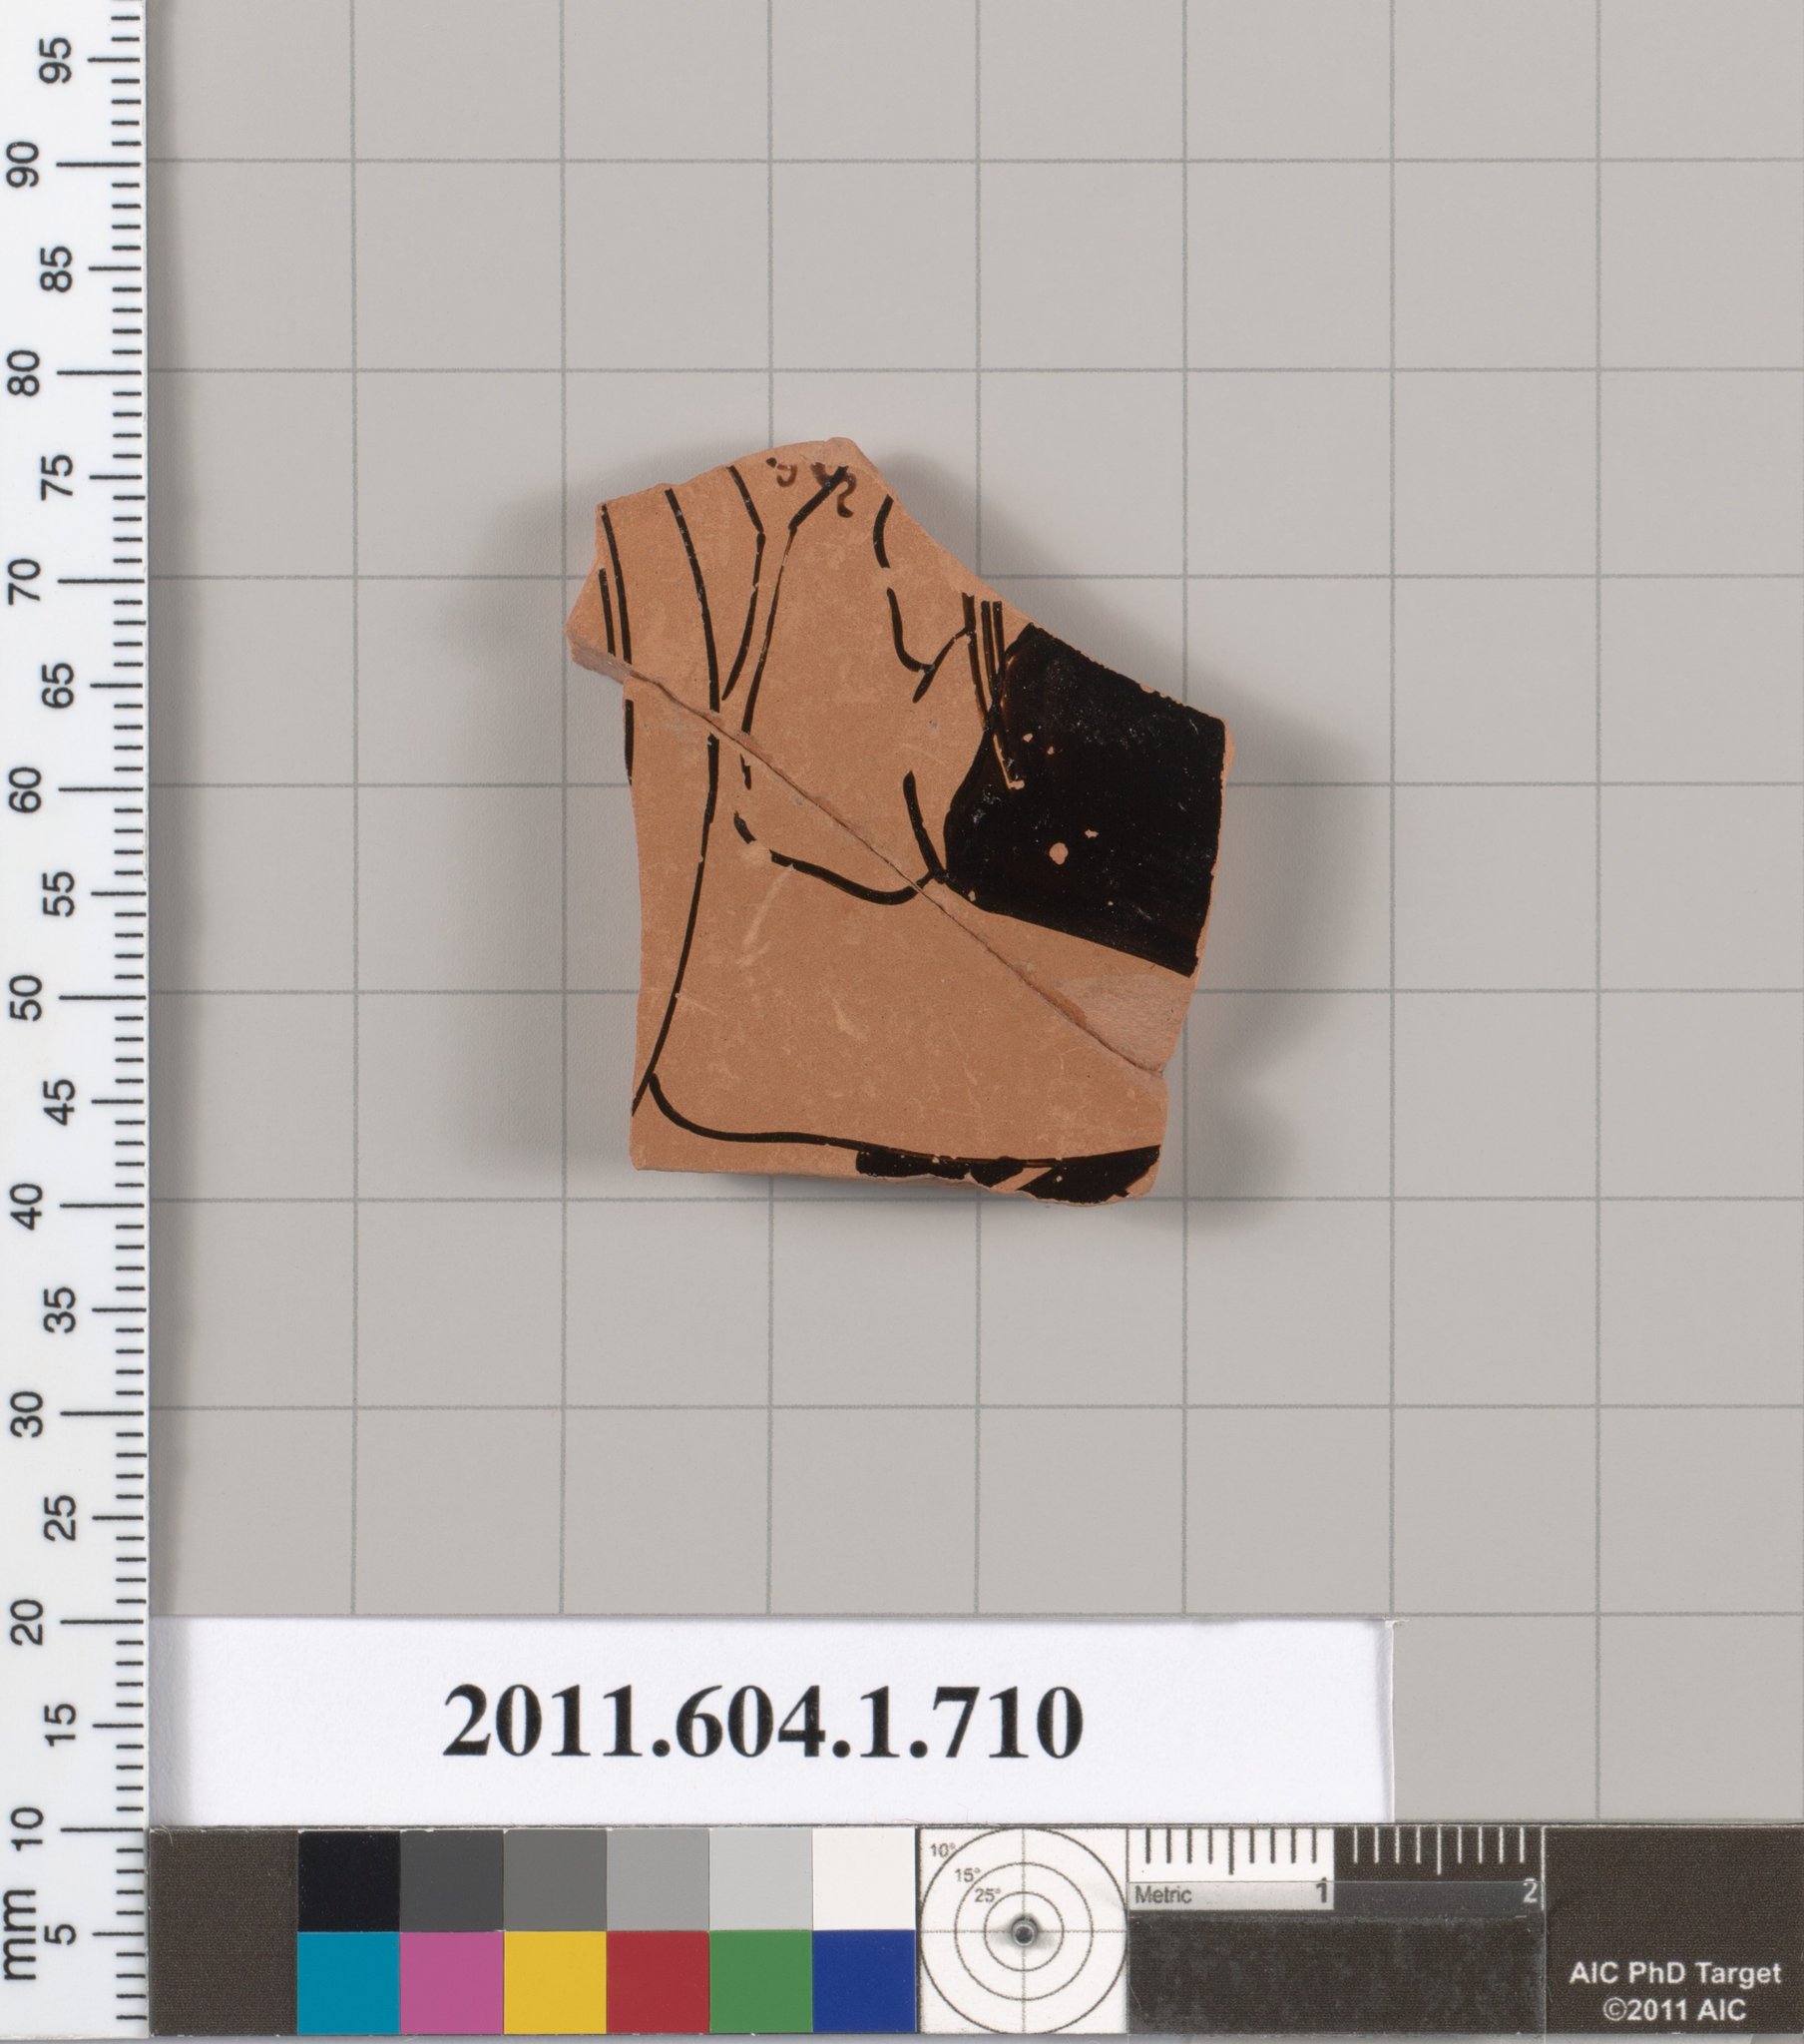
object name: kylix fragment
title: Terracotta fragment of a kylix (drinking cup)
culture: greek, attic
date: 500-476 BCE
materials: terracotta